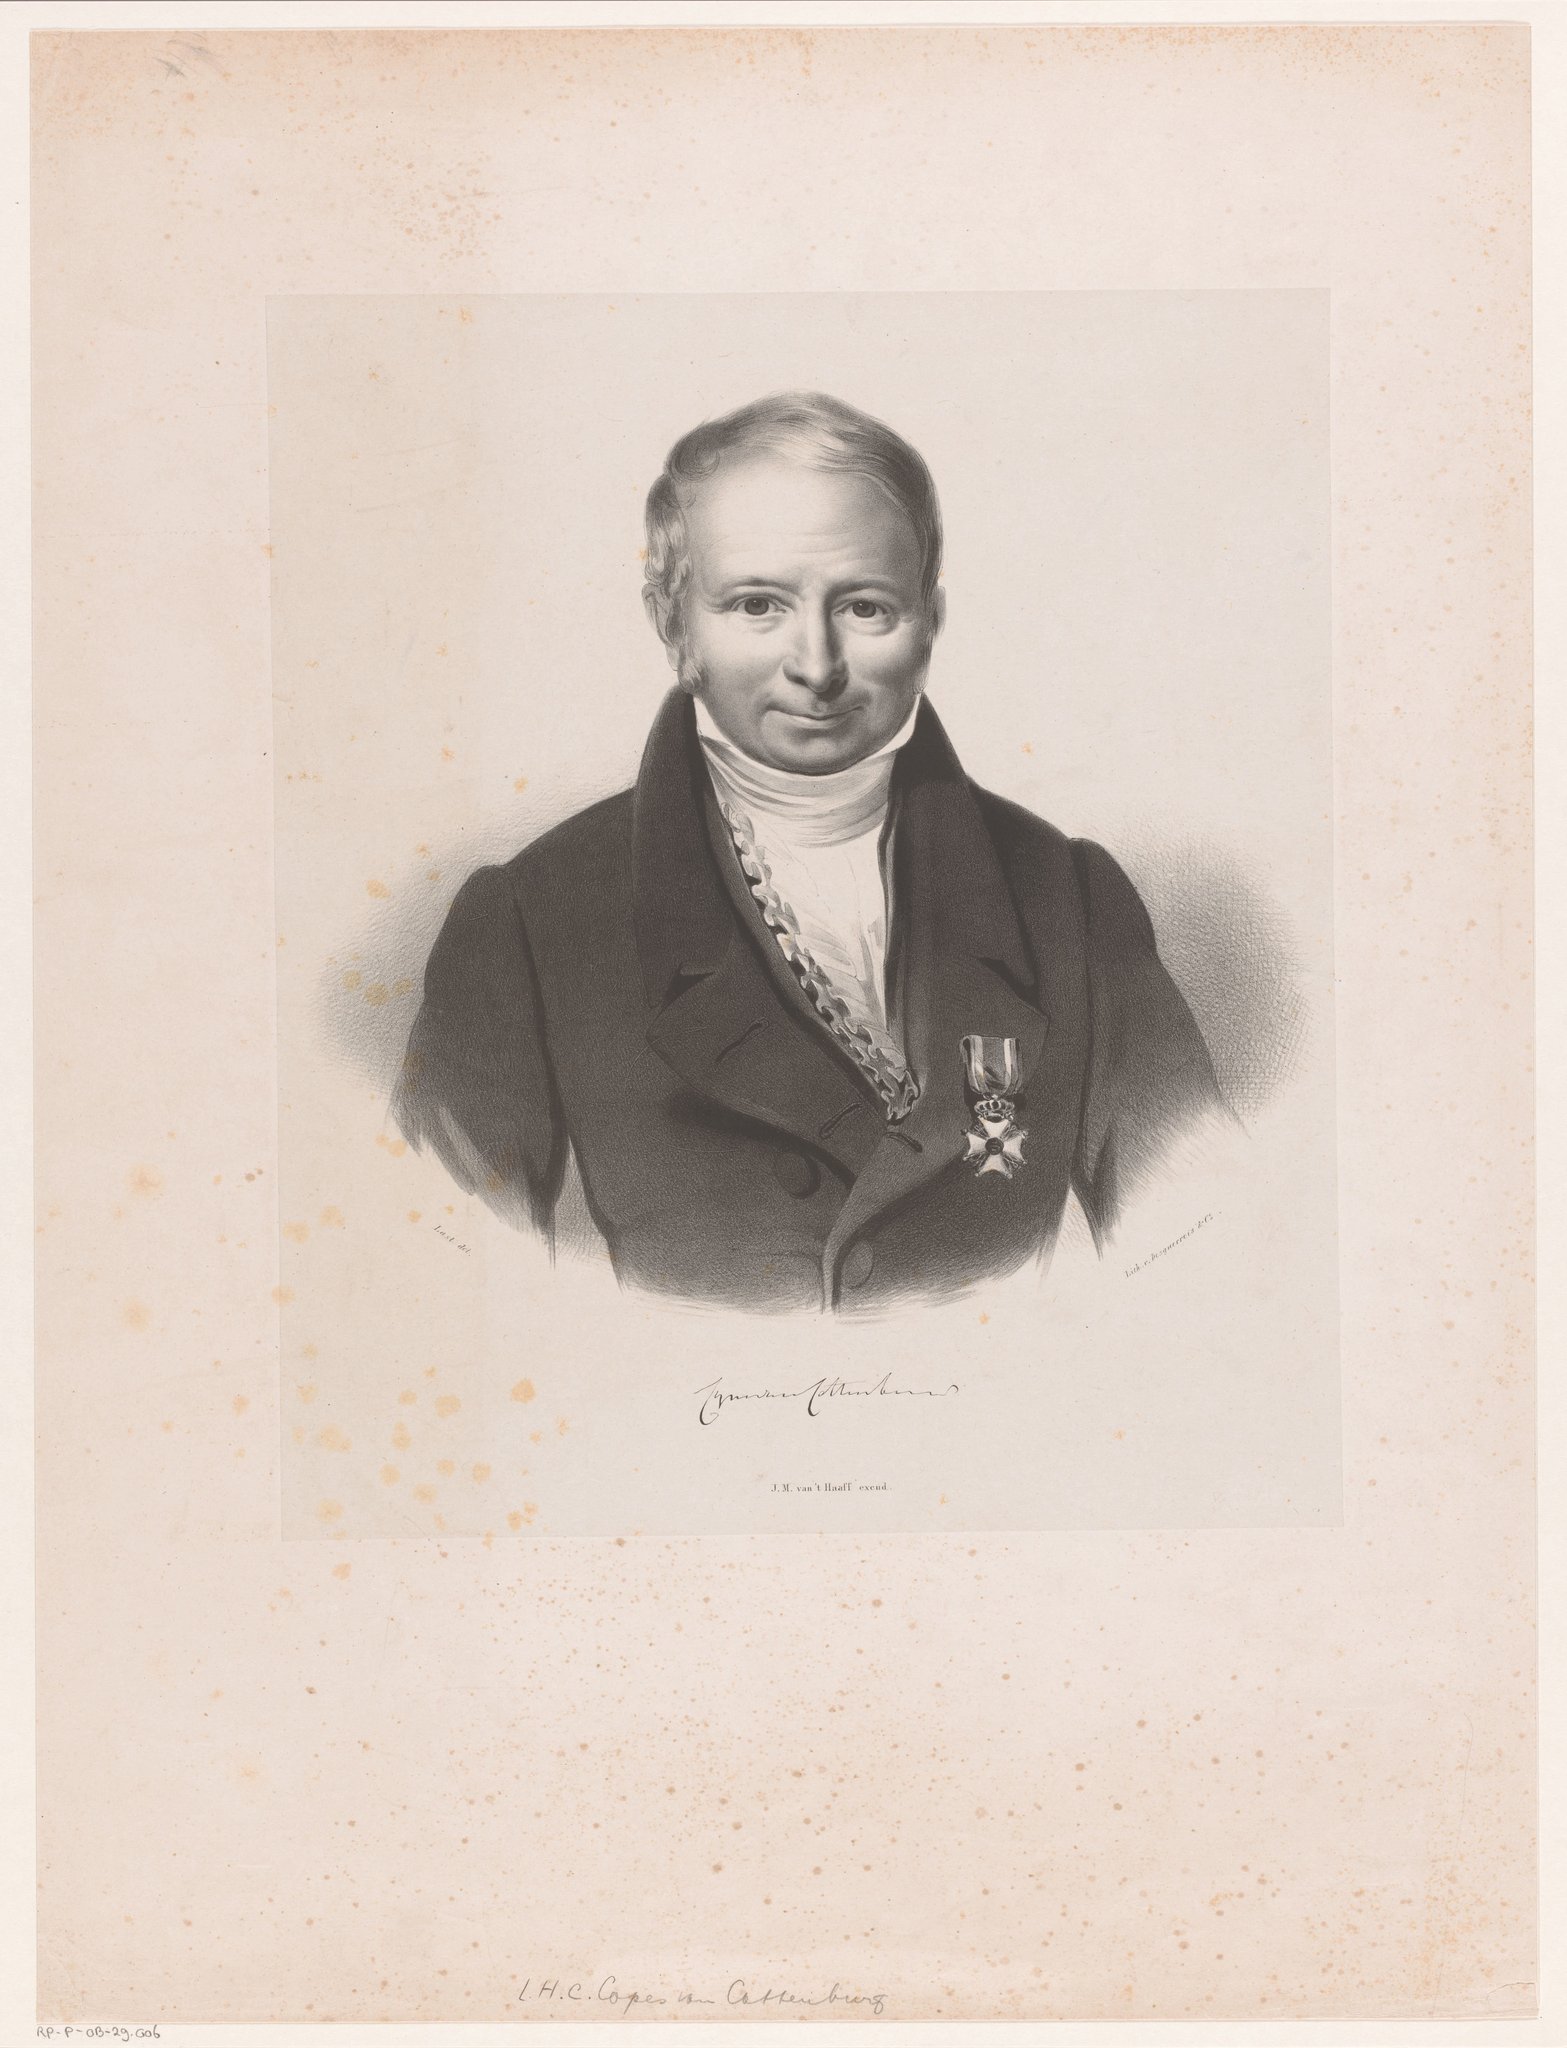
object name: print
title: Portret van Lodewijk Constantijn Rabo Copes van Cattenburch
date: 1818-1876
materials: paper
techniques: lithograph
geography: the hague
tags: mayor, knighthood order, historical persons (+ (full) bust portrait)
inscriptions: collector's mark: Lugt 2228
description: De geportretteerde draagt een ridderorde op de revers van zijn jas. Onder het portret zijn signatuur.